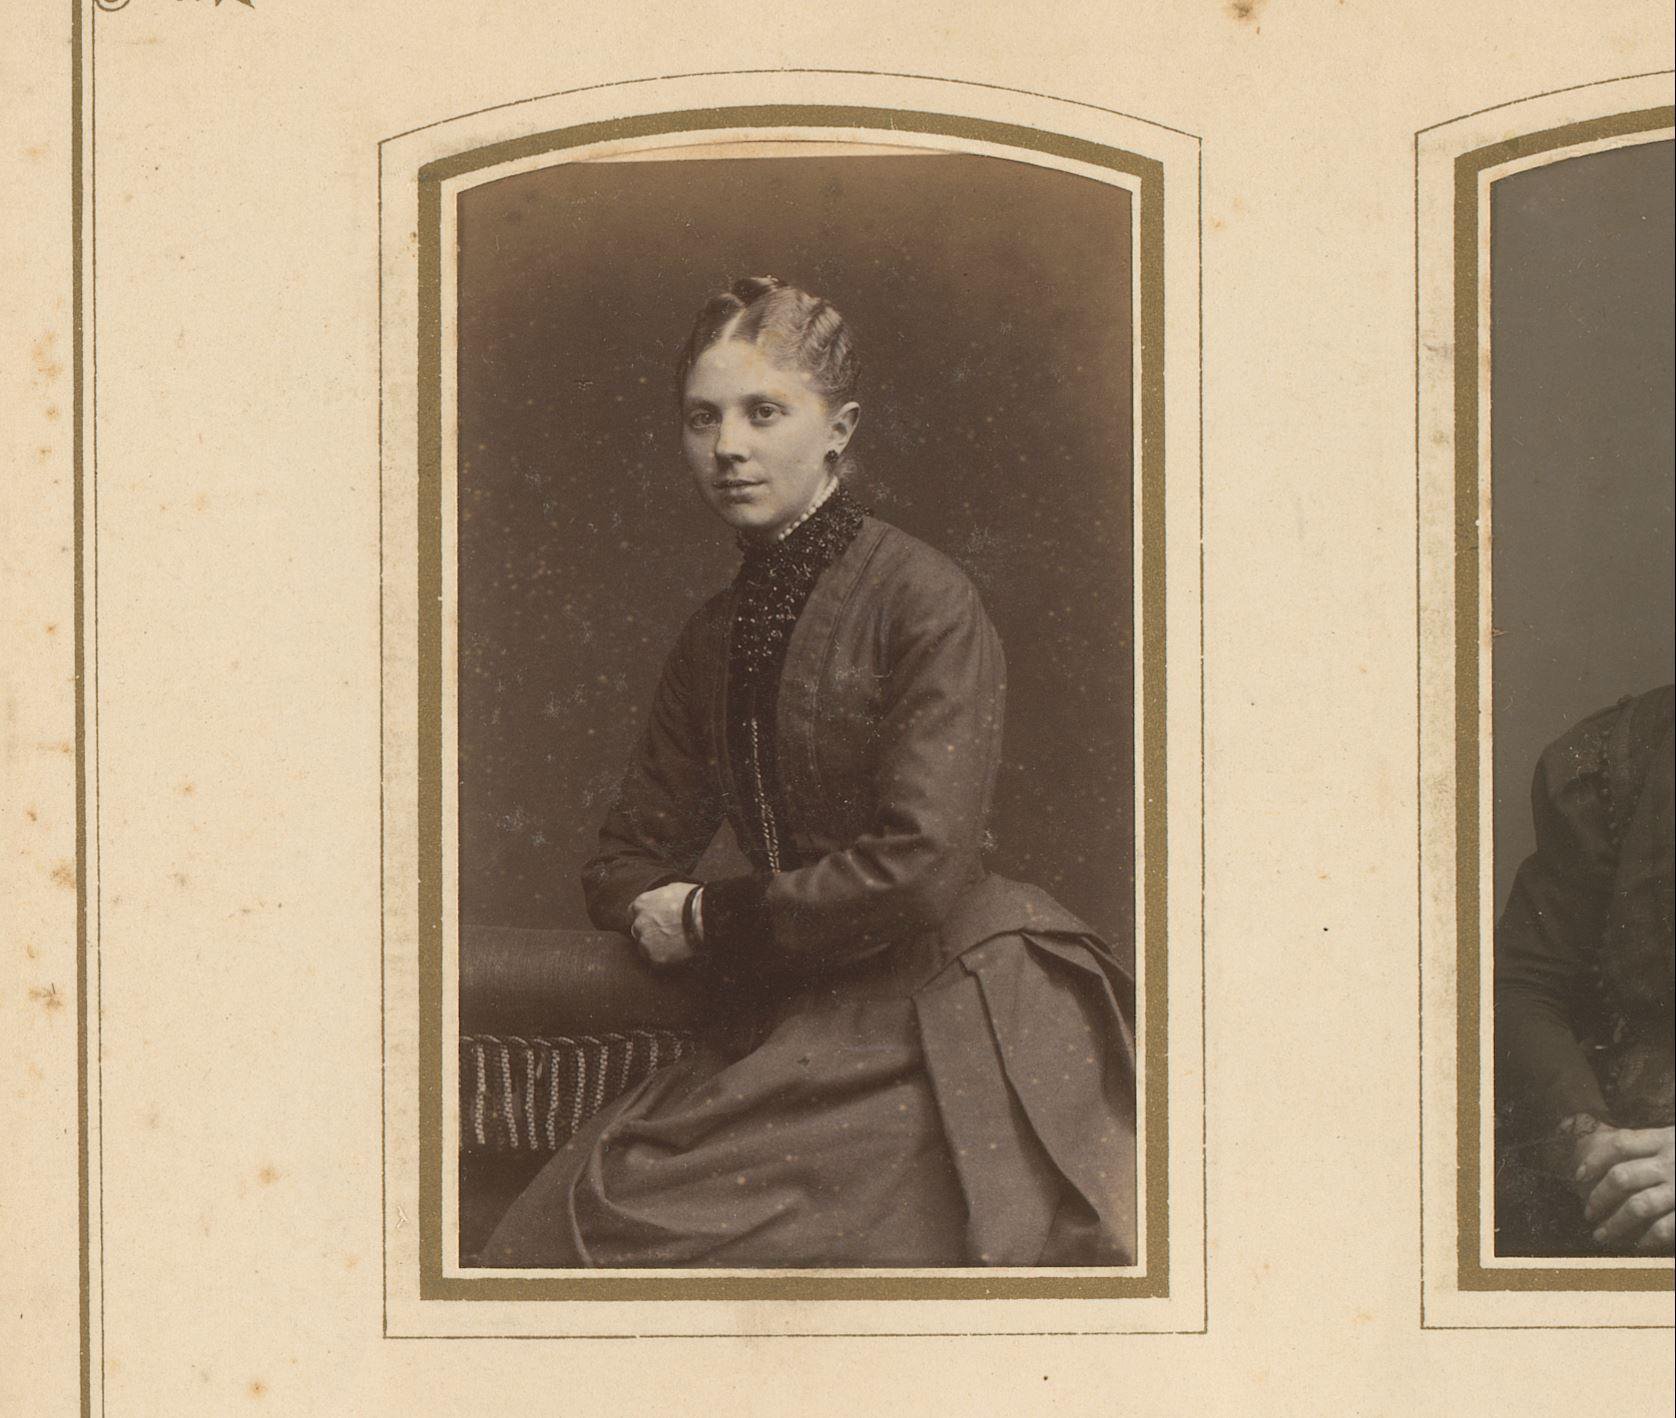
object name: carte de visite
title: Portret van een zittende vrouw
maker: willem carel heijenberg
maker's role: fotograaf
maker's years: 1835-1895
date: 1885-1895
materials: cardboard, photographic support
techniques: albumen print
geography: utrecht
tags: sitting figure - aa - female human figure, historical persons - bb - woman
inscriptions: inscription: ‘DEM/ VERDIENSTE/ BERLIN/ 1885/ W. C. HEIJENBERG/ PHOTOGRAPHE/ UTRECHT/ Nachtegaalstraat No. 40./ Deze Portretten kunnen nabesteld worden.’